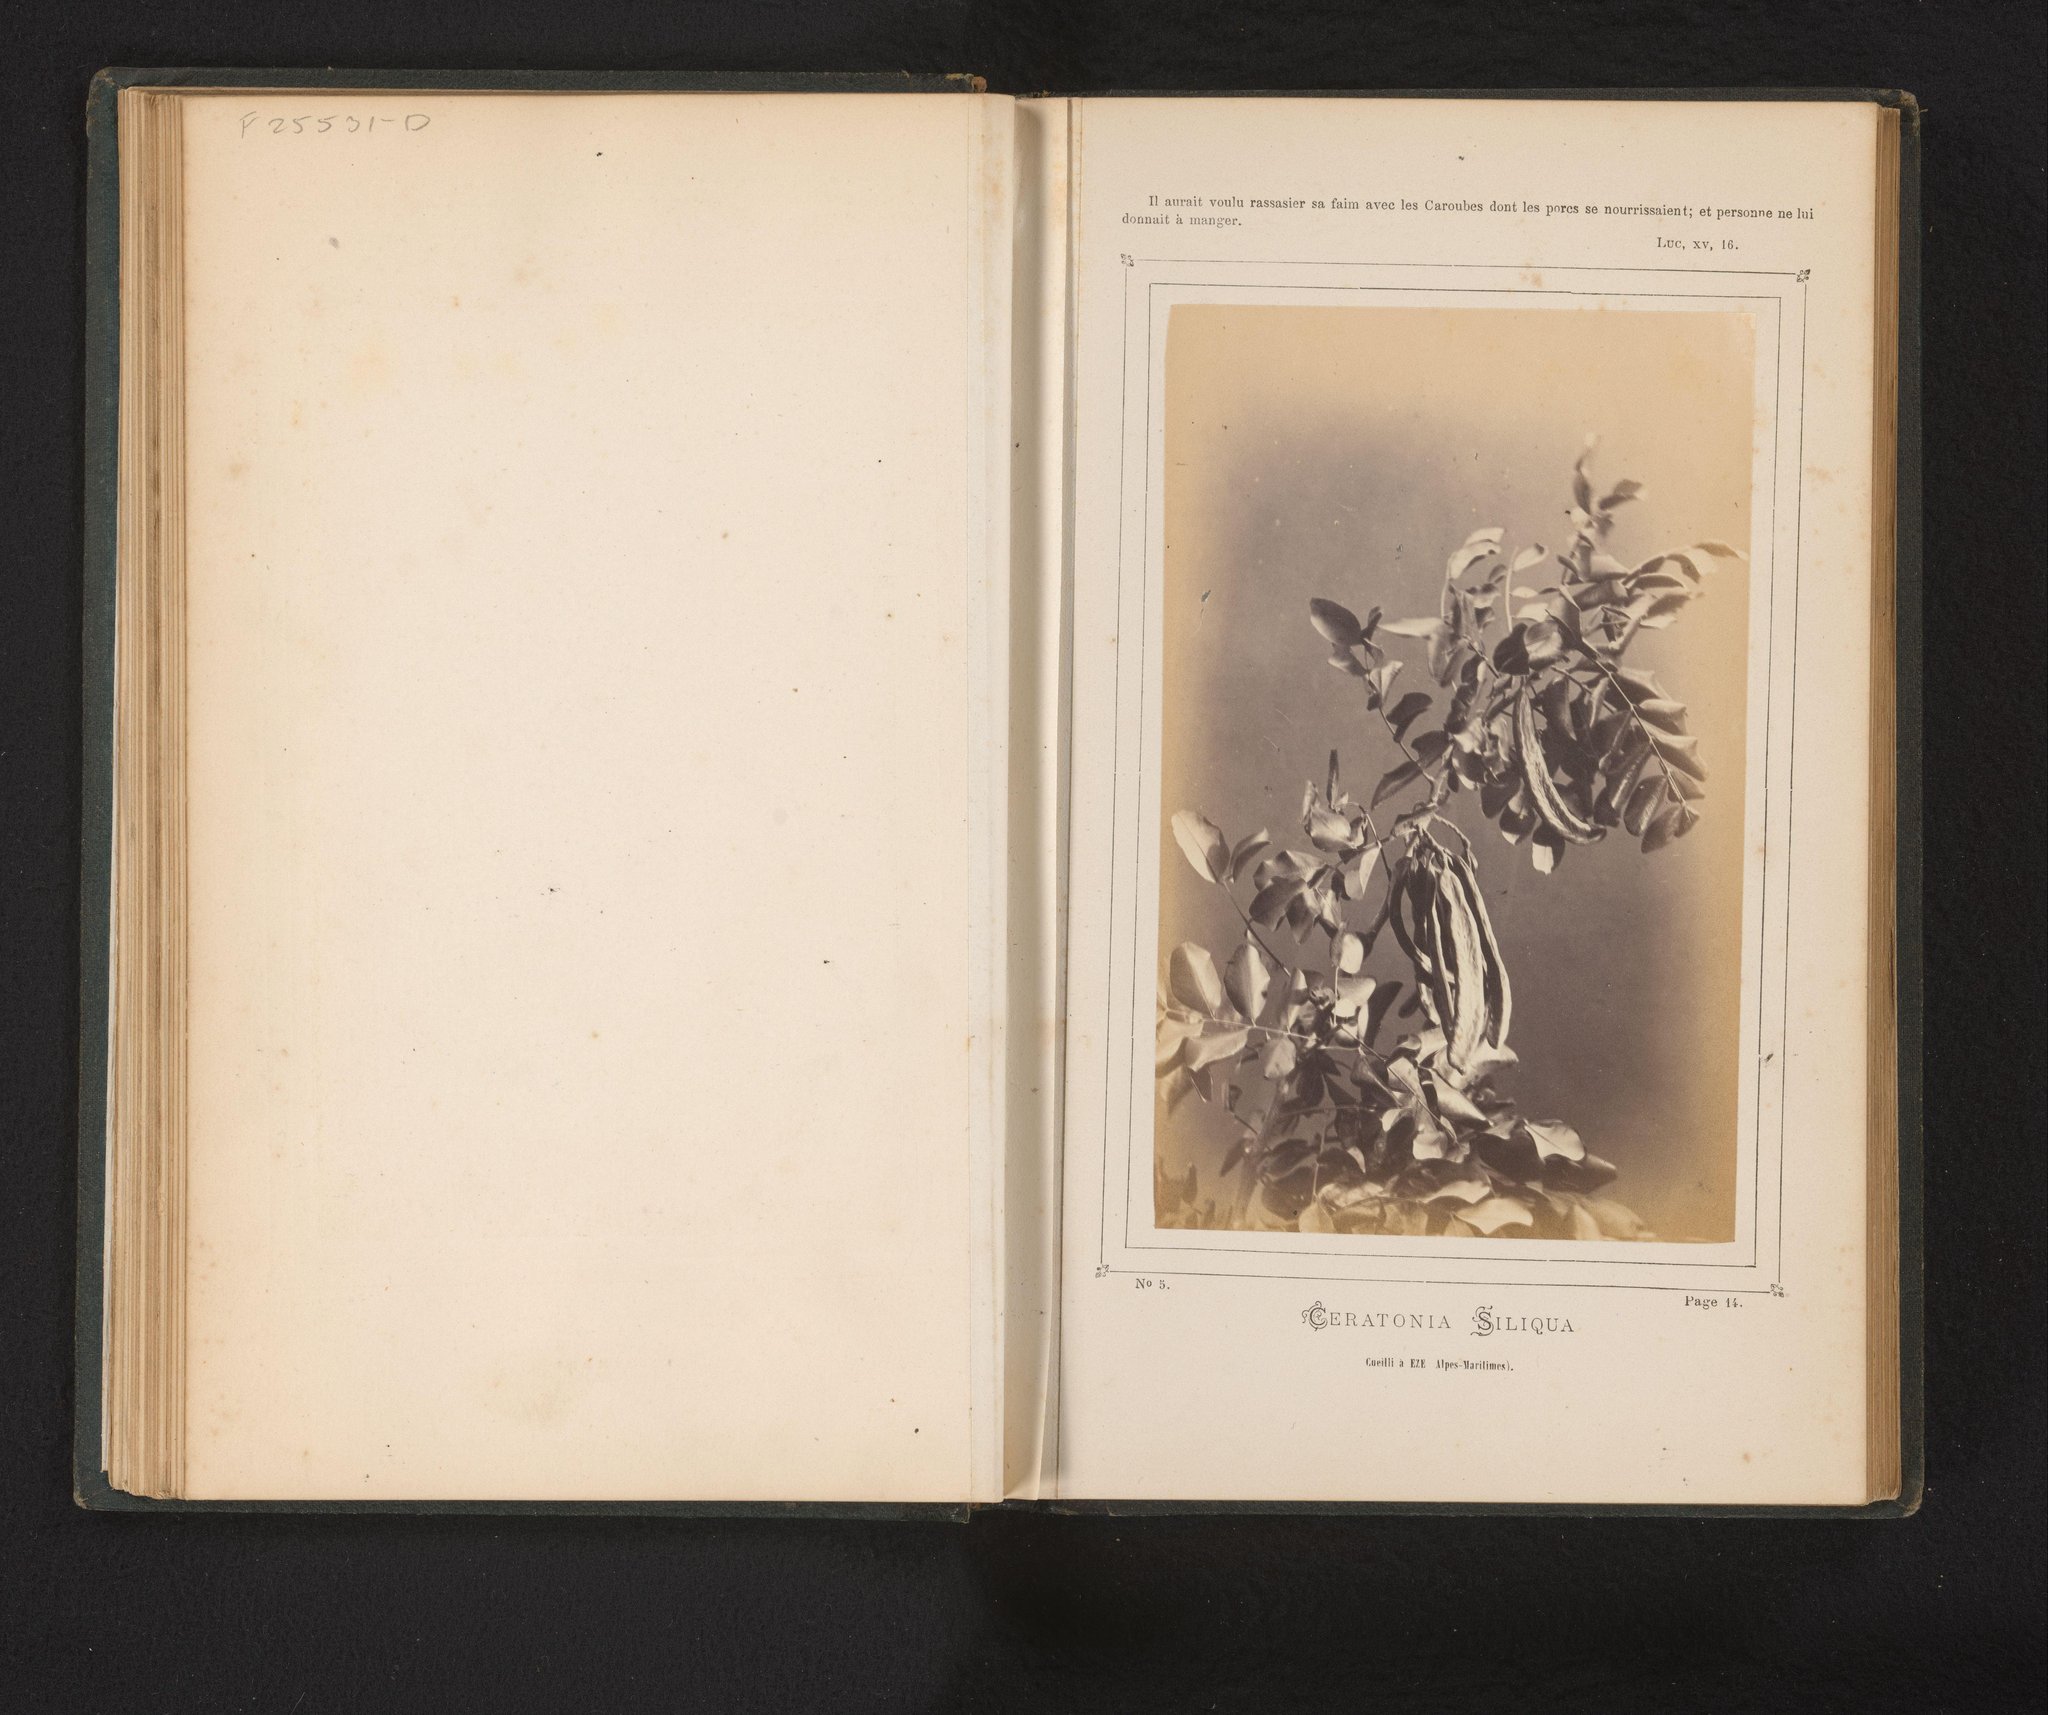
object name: page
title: Ceratonia Siliqua. Cueilli à Eze, Alpes Maritimes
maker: jean walburg de bray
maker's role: fotograaf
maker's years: 1839-1901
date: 1866-1871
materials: paper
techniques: albumen print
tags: shrubs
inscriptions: inscription: ‘Il aurait voulu rassasier sa faim avec les Caroues dont les porcs se nourrissaient; et personne ne lui/ donnait à manger./ LUC, XV, 16.’, inscription: ‘Page 14.’, number: ‘No 5.’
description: Foto op derde ongenummerde pagina na pagina 14.